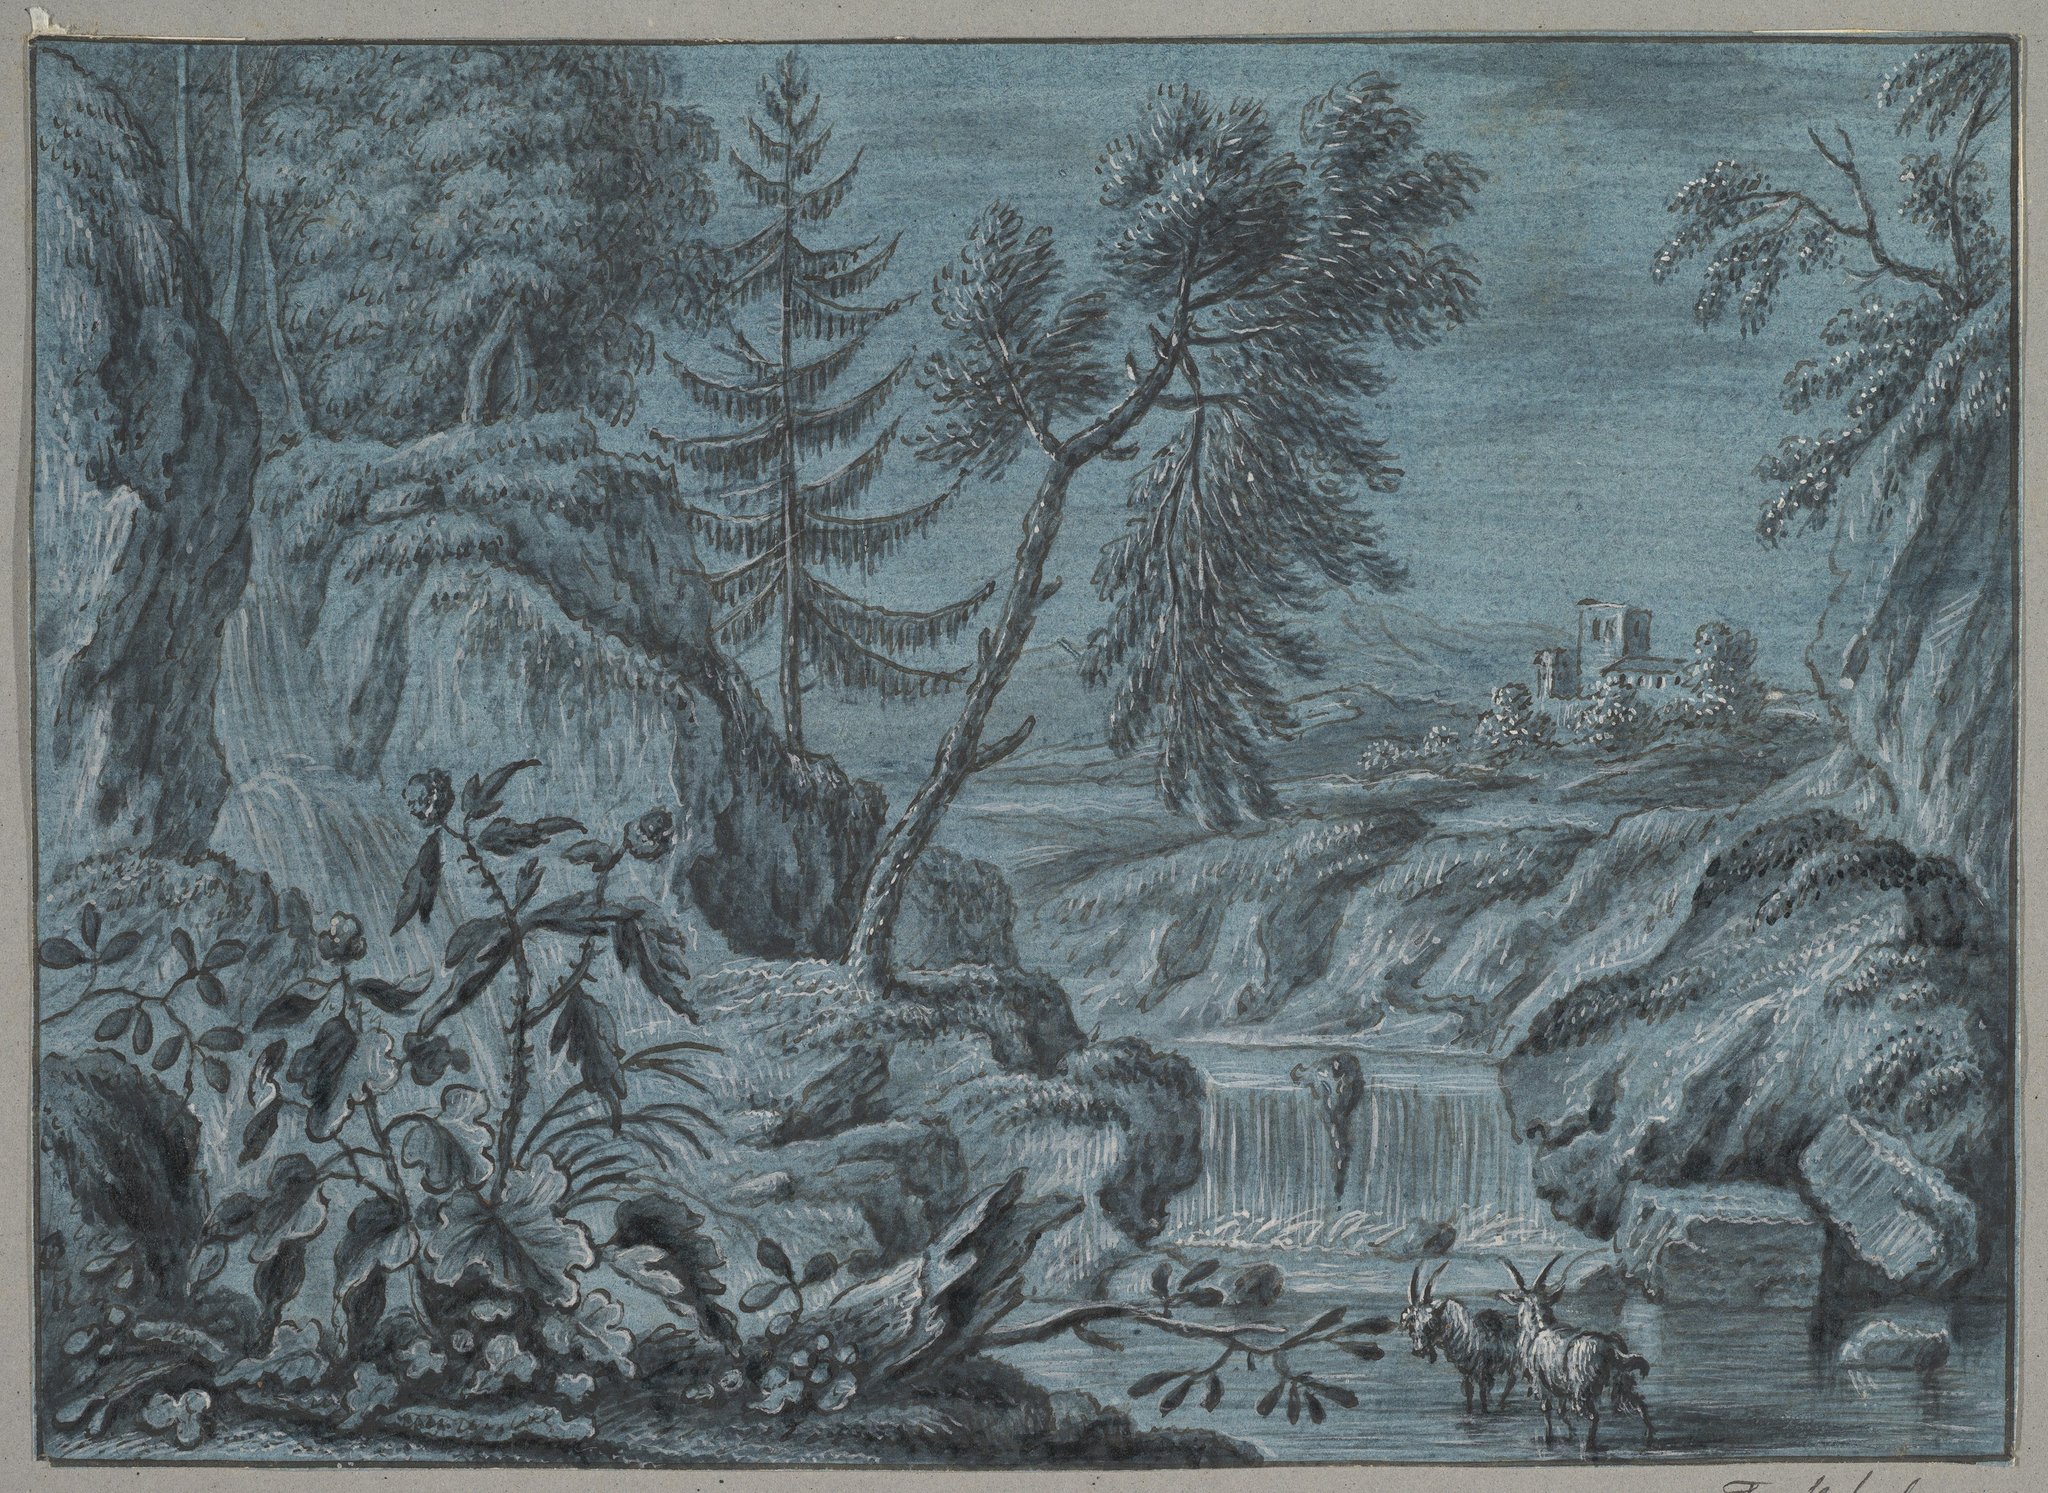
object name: drawing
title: Southern Landscape with a Waterfall and Goats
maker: ferdinand kobell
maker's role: artist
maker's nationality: german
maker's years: 1740-1799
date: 1767-1800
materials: gouache, ink, paper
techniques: heightening, pen, wash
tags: goats,waterfalls,landscapes,plants